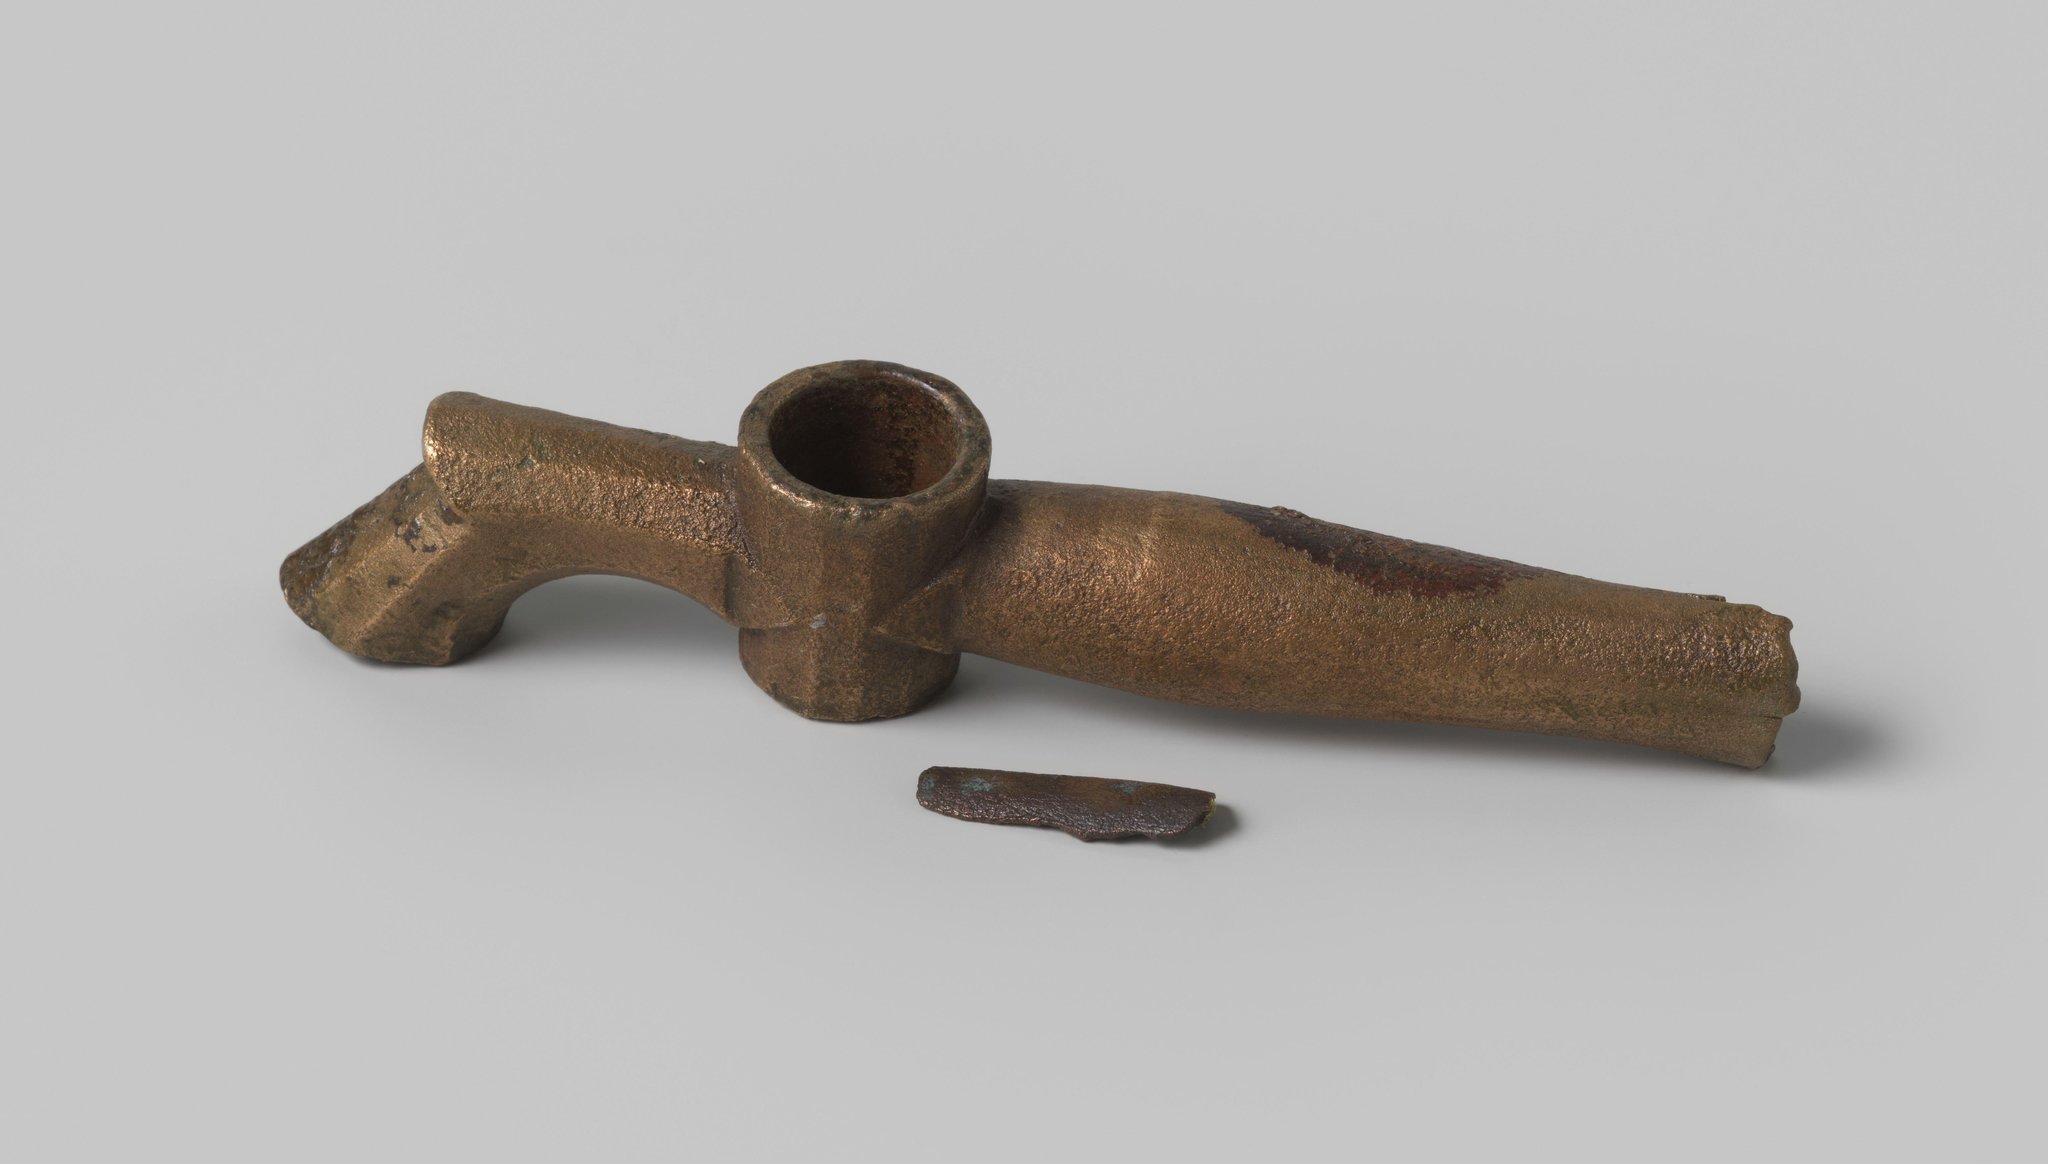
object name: tap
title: Kraan uit het wrak van de Oost-Indiëvaarder Hollandia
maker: Anonymous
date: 1700-1743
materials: copper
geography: netherlands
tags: verenigde oostindische compagnie, hollandia (schip), annet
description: Tap, part of tap; tube, circular in section, tapering towards end (broken), faceted spout with upper side projecting, tapering barrel for spigot.